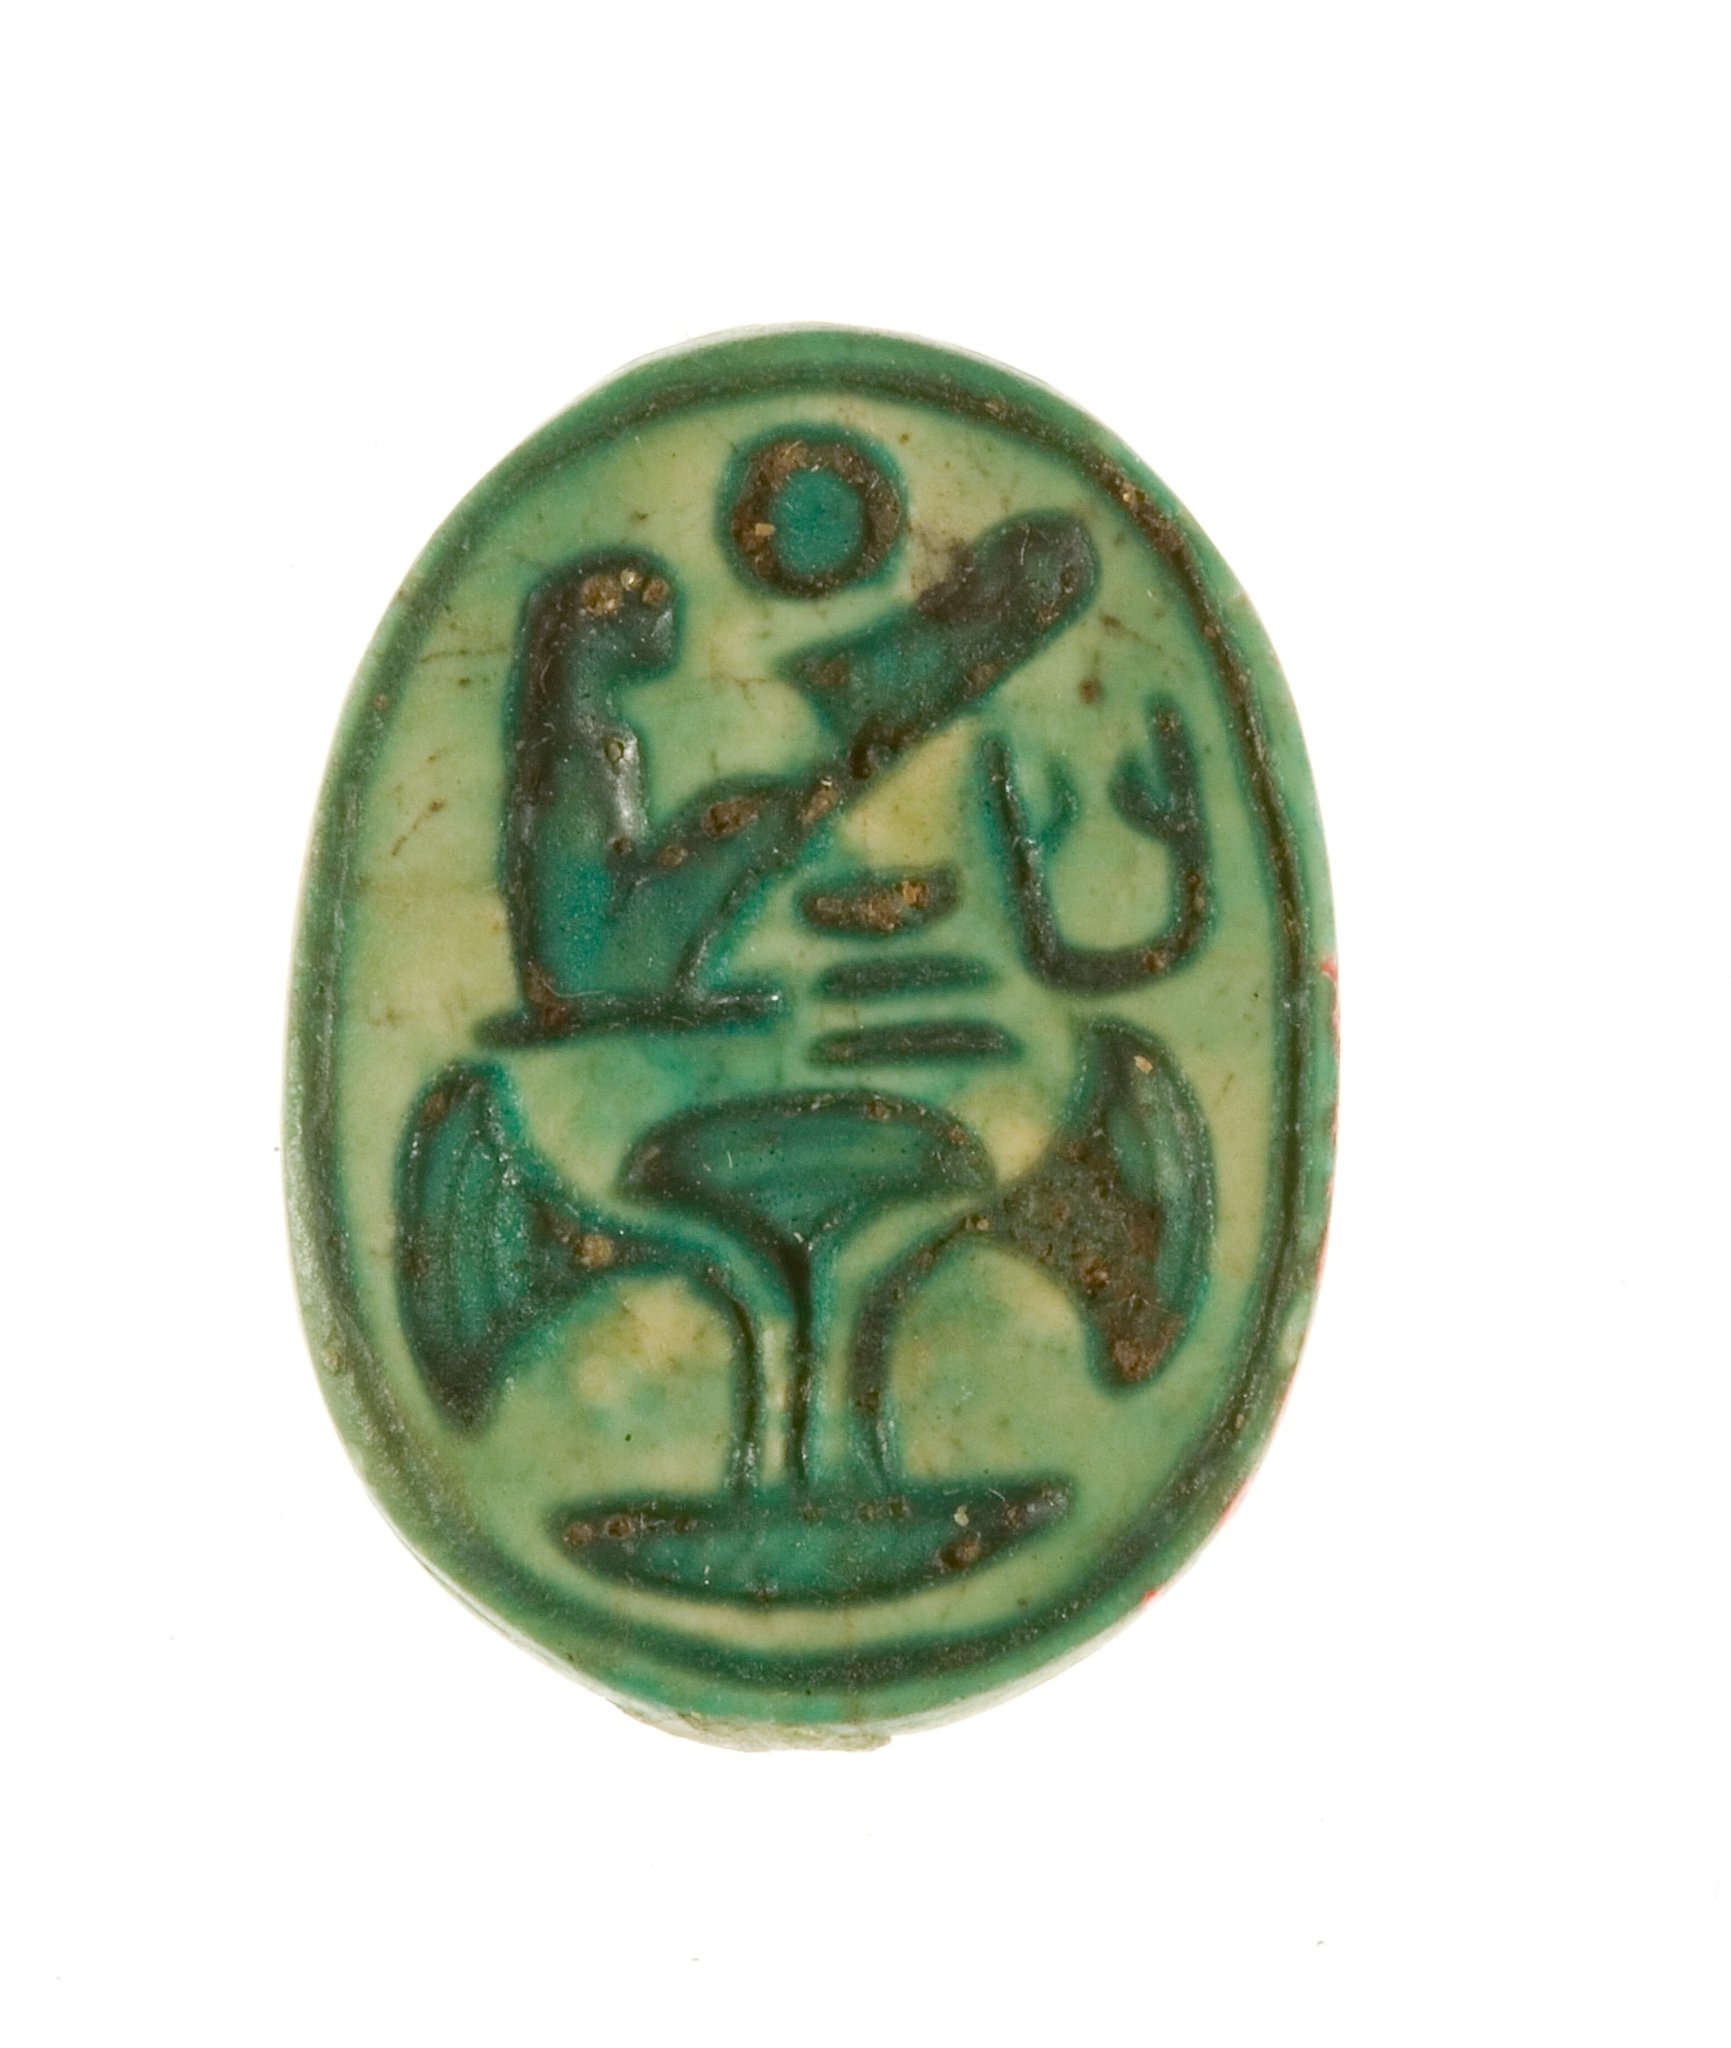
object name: scarab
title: Scarab Inscribed Lord of the Two Lands Maatkare Above a Papyrus Thicket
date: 1479-1458 BCE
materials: stone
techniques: glazing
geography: egypt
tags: hieroglyphs,scarabs